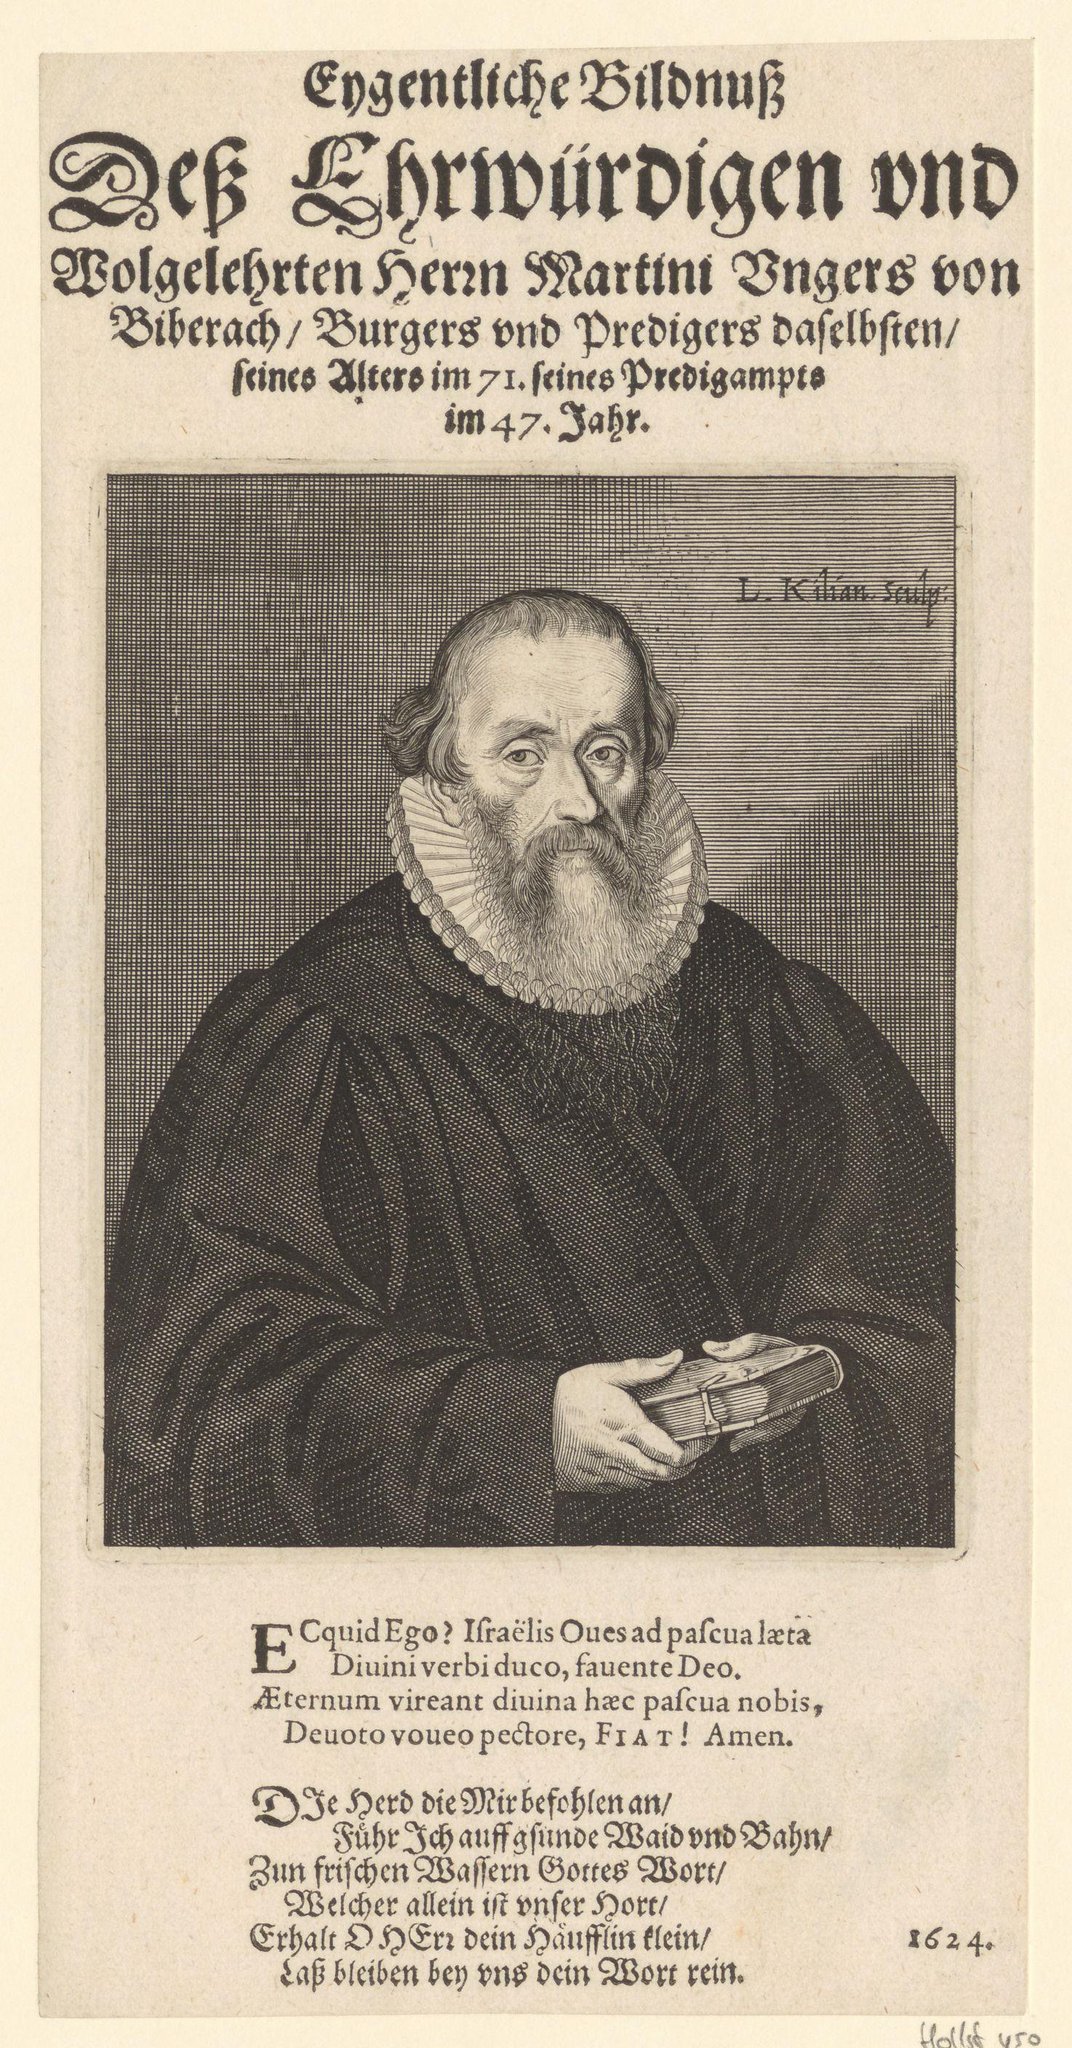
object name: print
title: Portret van Martin Unger op 71-jarige leeftijd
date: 1624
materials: paper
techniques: engraving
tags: theologian, historical persons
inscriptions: collector's mark: Lugt 2228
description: Tekst in het Duits en het Latijn in boekdruk op het blad.